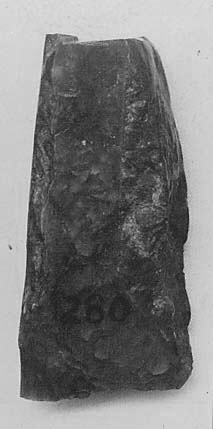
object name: adze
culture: russian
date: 1902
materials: jade